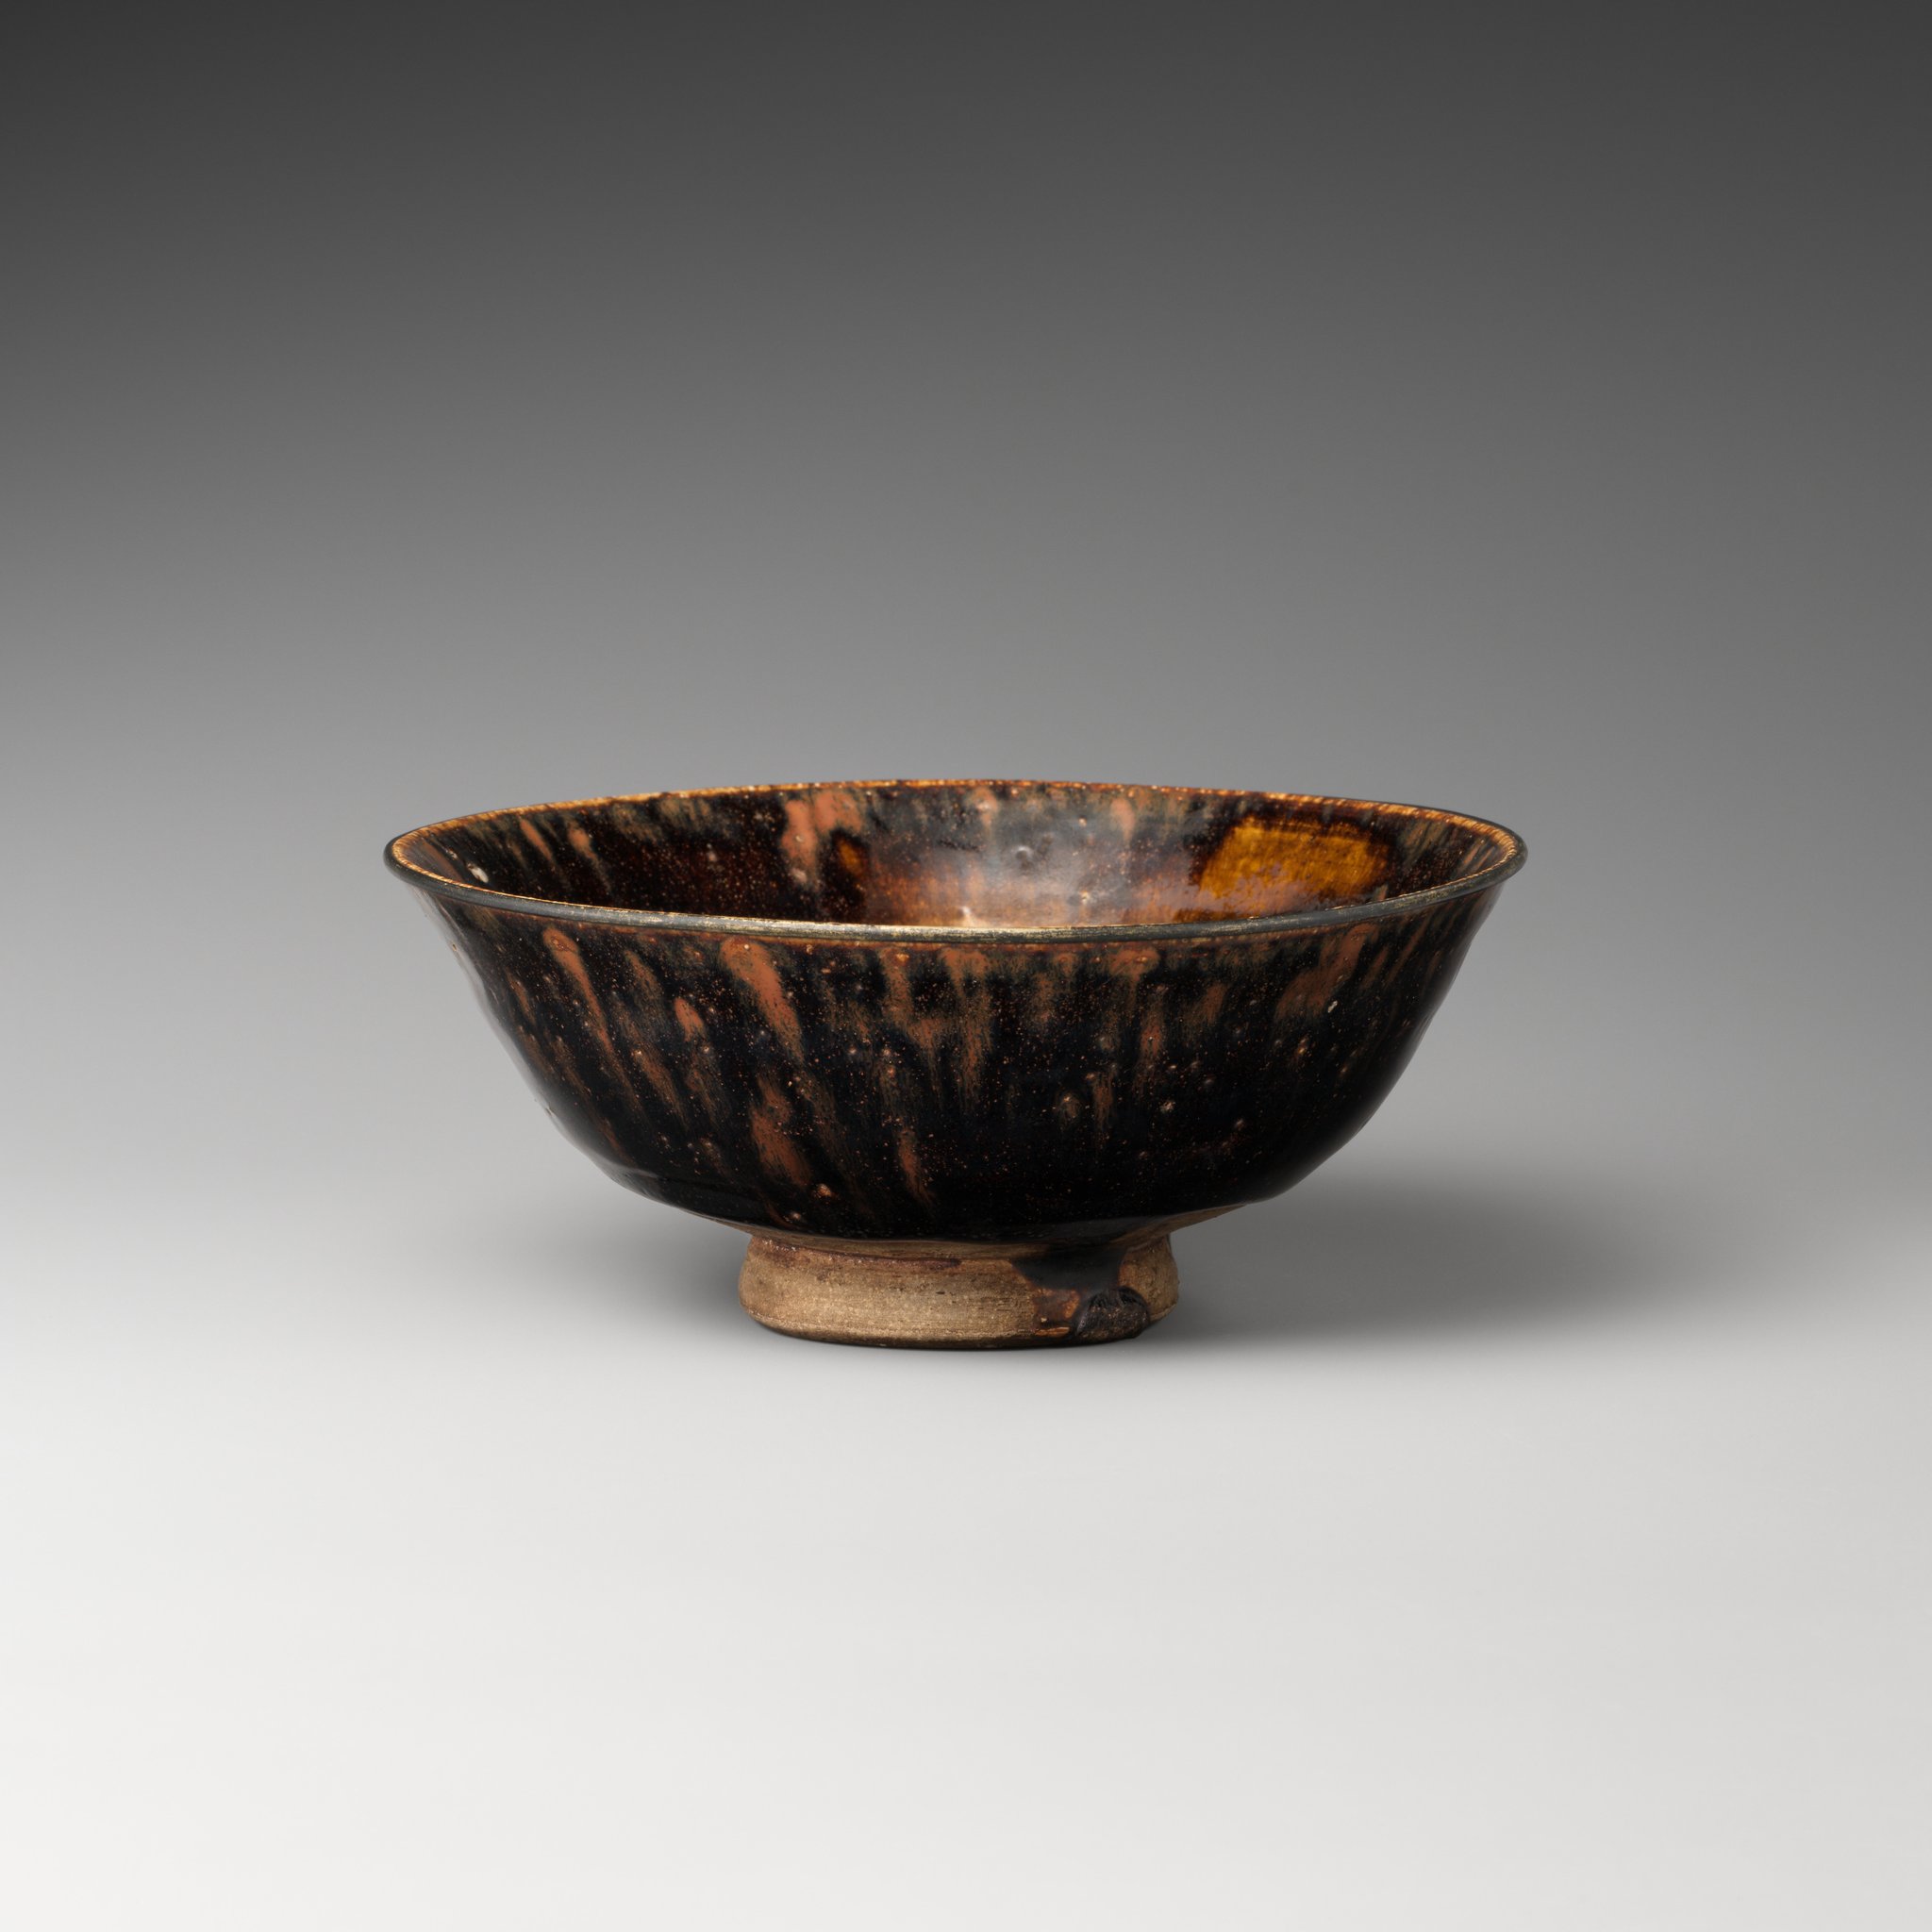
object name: teabowl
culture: japanese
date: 1601-1700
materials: brass, glaze, paste